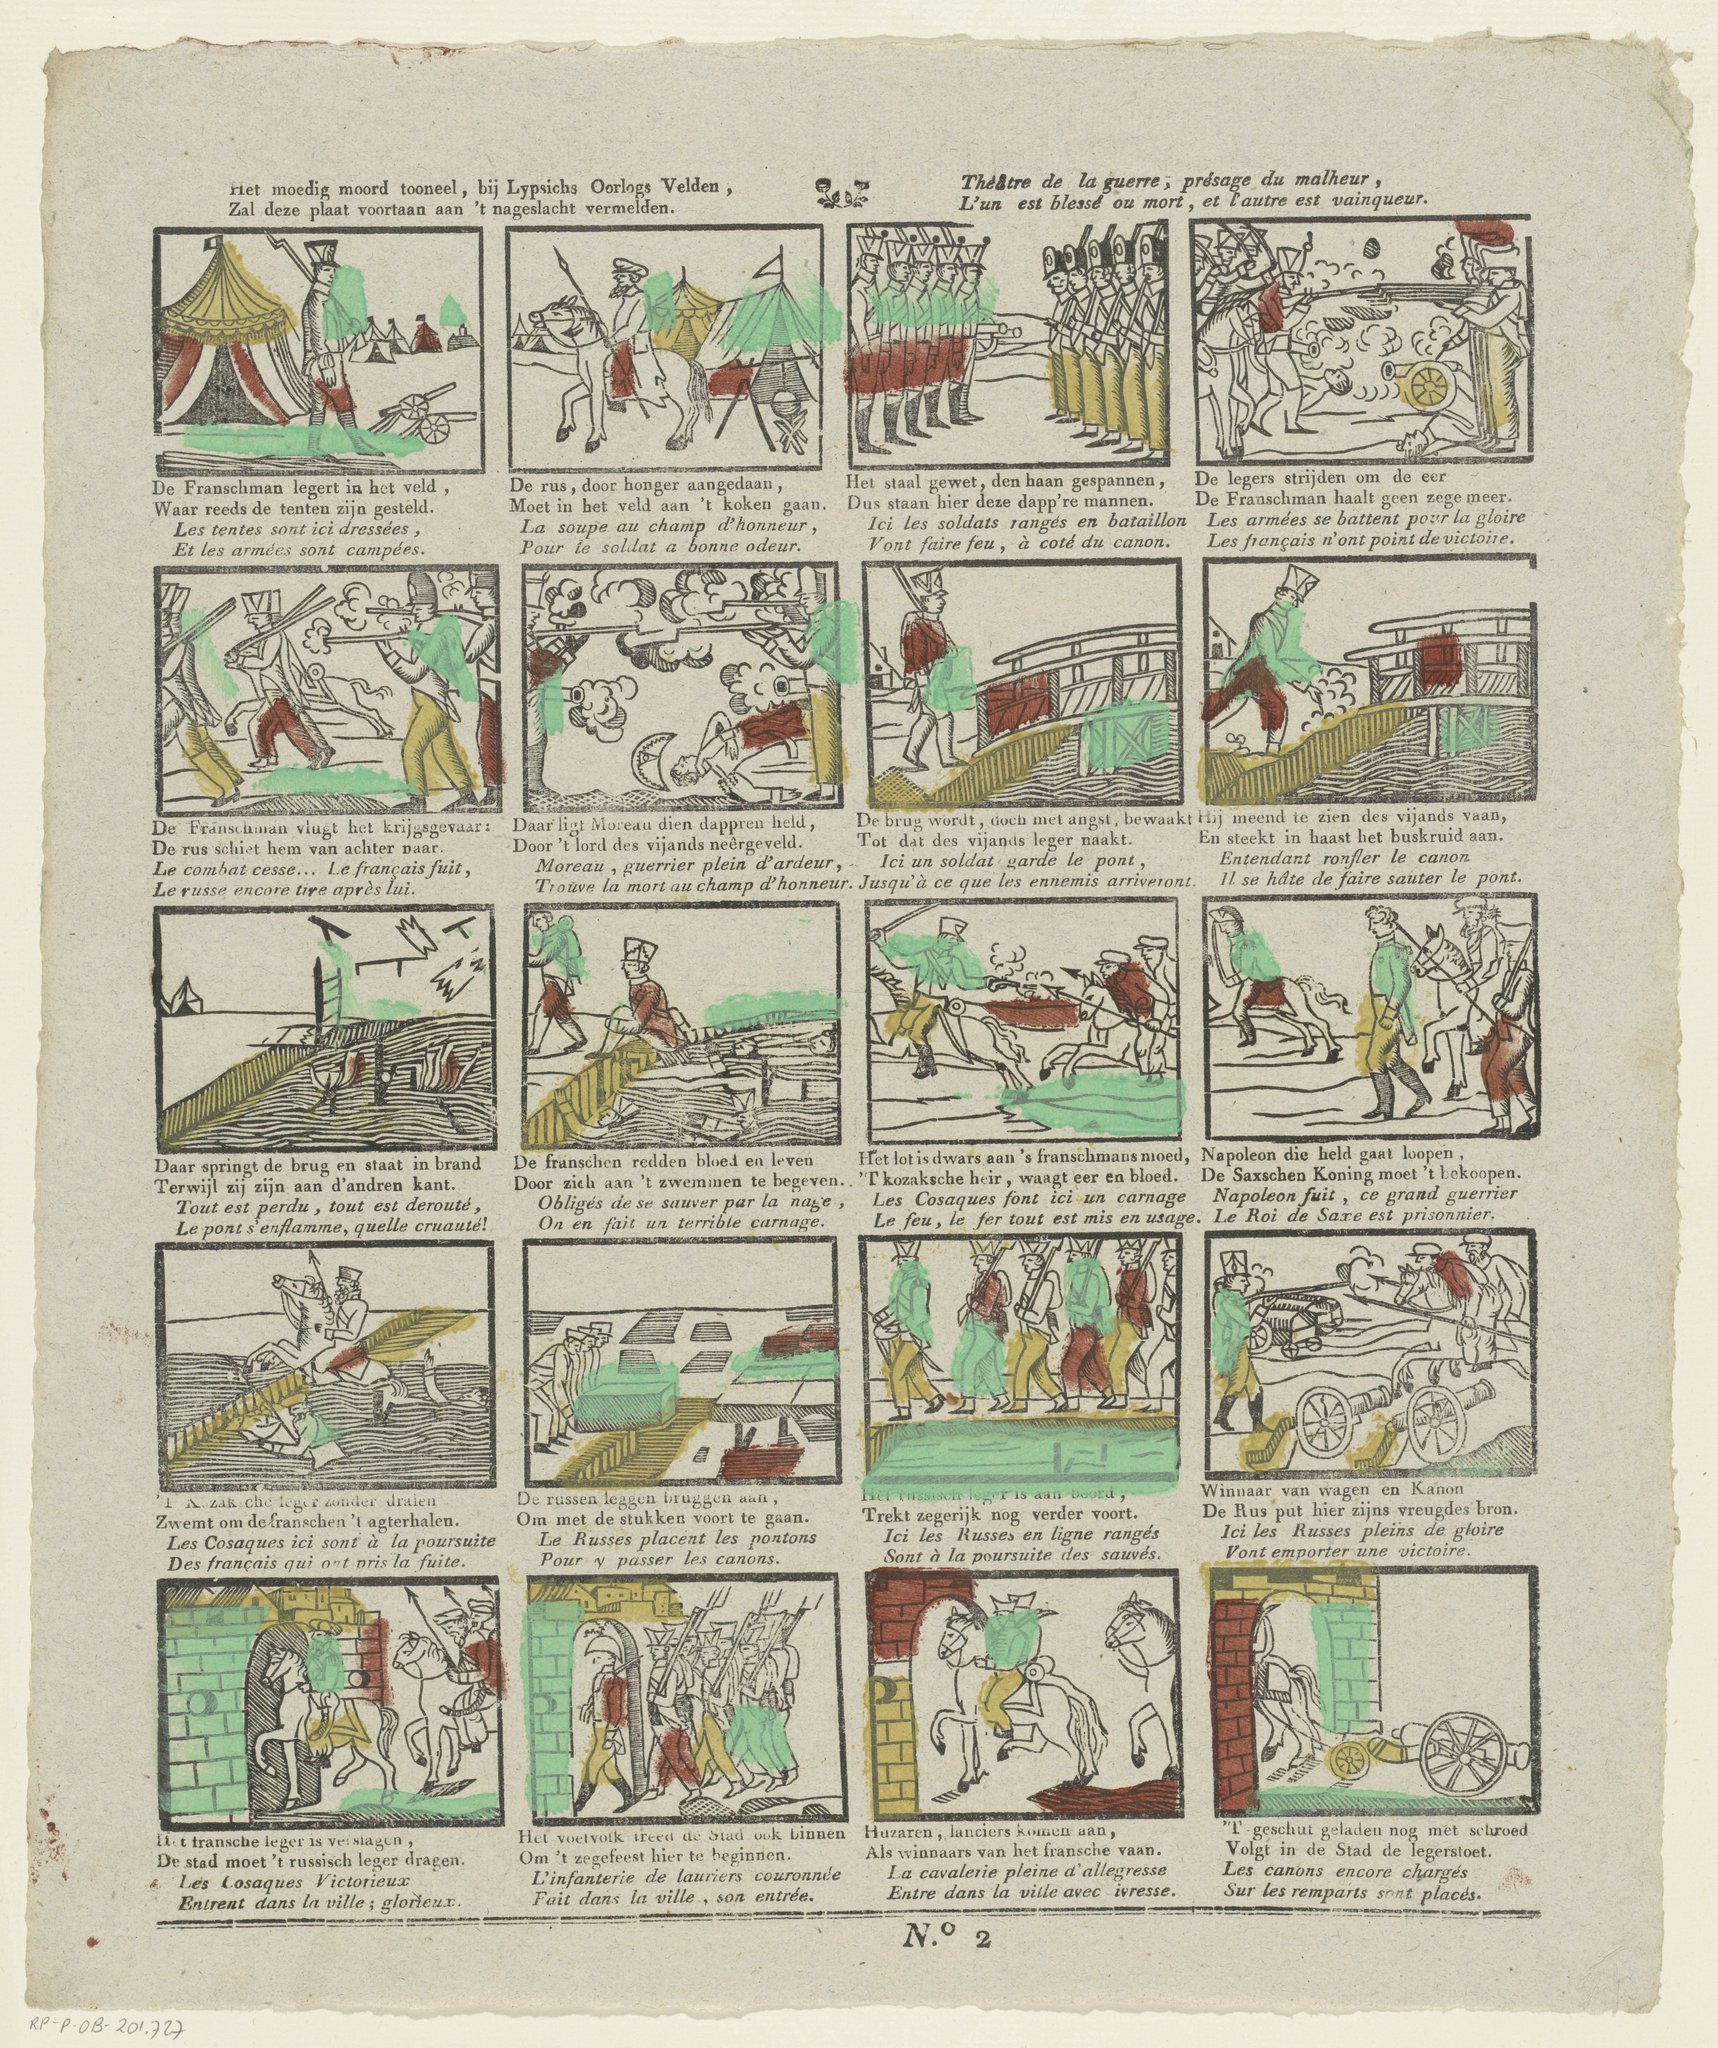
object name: print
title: Het moedig moord toneel, bij Lypsichs oorlog Velden, / Zal deze plaat voortaan aan 't nageslacht vermelden / Théatre de la guerre, présage du malheur, / L'un est blessé ou mort, et l'autre est vainqueur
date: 1800-1833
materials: paper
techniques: colour, letterpress printing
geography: turnhout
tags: battle, the soldier; the soldier's life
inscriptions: collector's mark: Lugt 2760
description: Blad met 20 voorstellingen de Slag bij Leipzig. Onder elke voorstelling een tweeregelig vers in het Nederlands en in het Frans. Genummerd midden onder: No. 2.